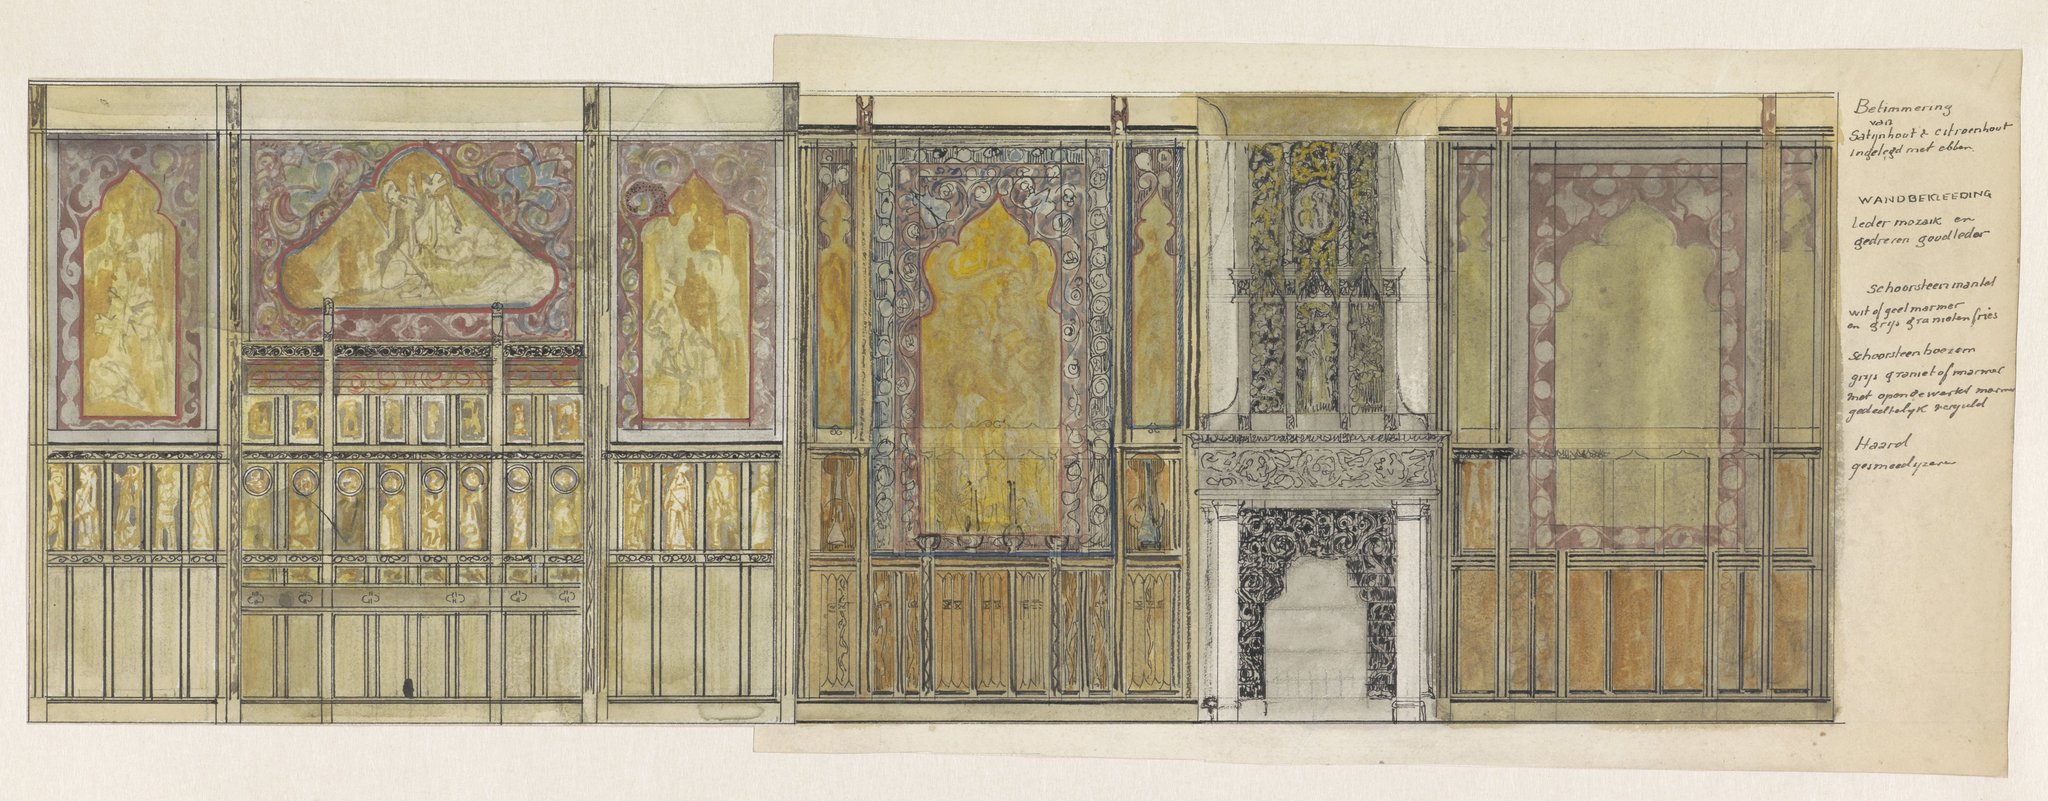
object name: drawing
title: Ontwerp voor een wandbekleding en schoorsteenmantel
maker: carel adolph lion cachet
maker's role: draughtsman, print maker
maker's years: 1864-1945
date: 1874-1945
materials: ink, paper, pencil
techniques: brush, pen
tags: wall-covering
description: Ontwerp op twee aan elkaar geplakte bladen voor een wandbekleding en schoorsteenmantel.